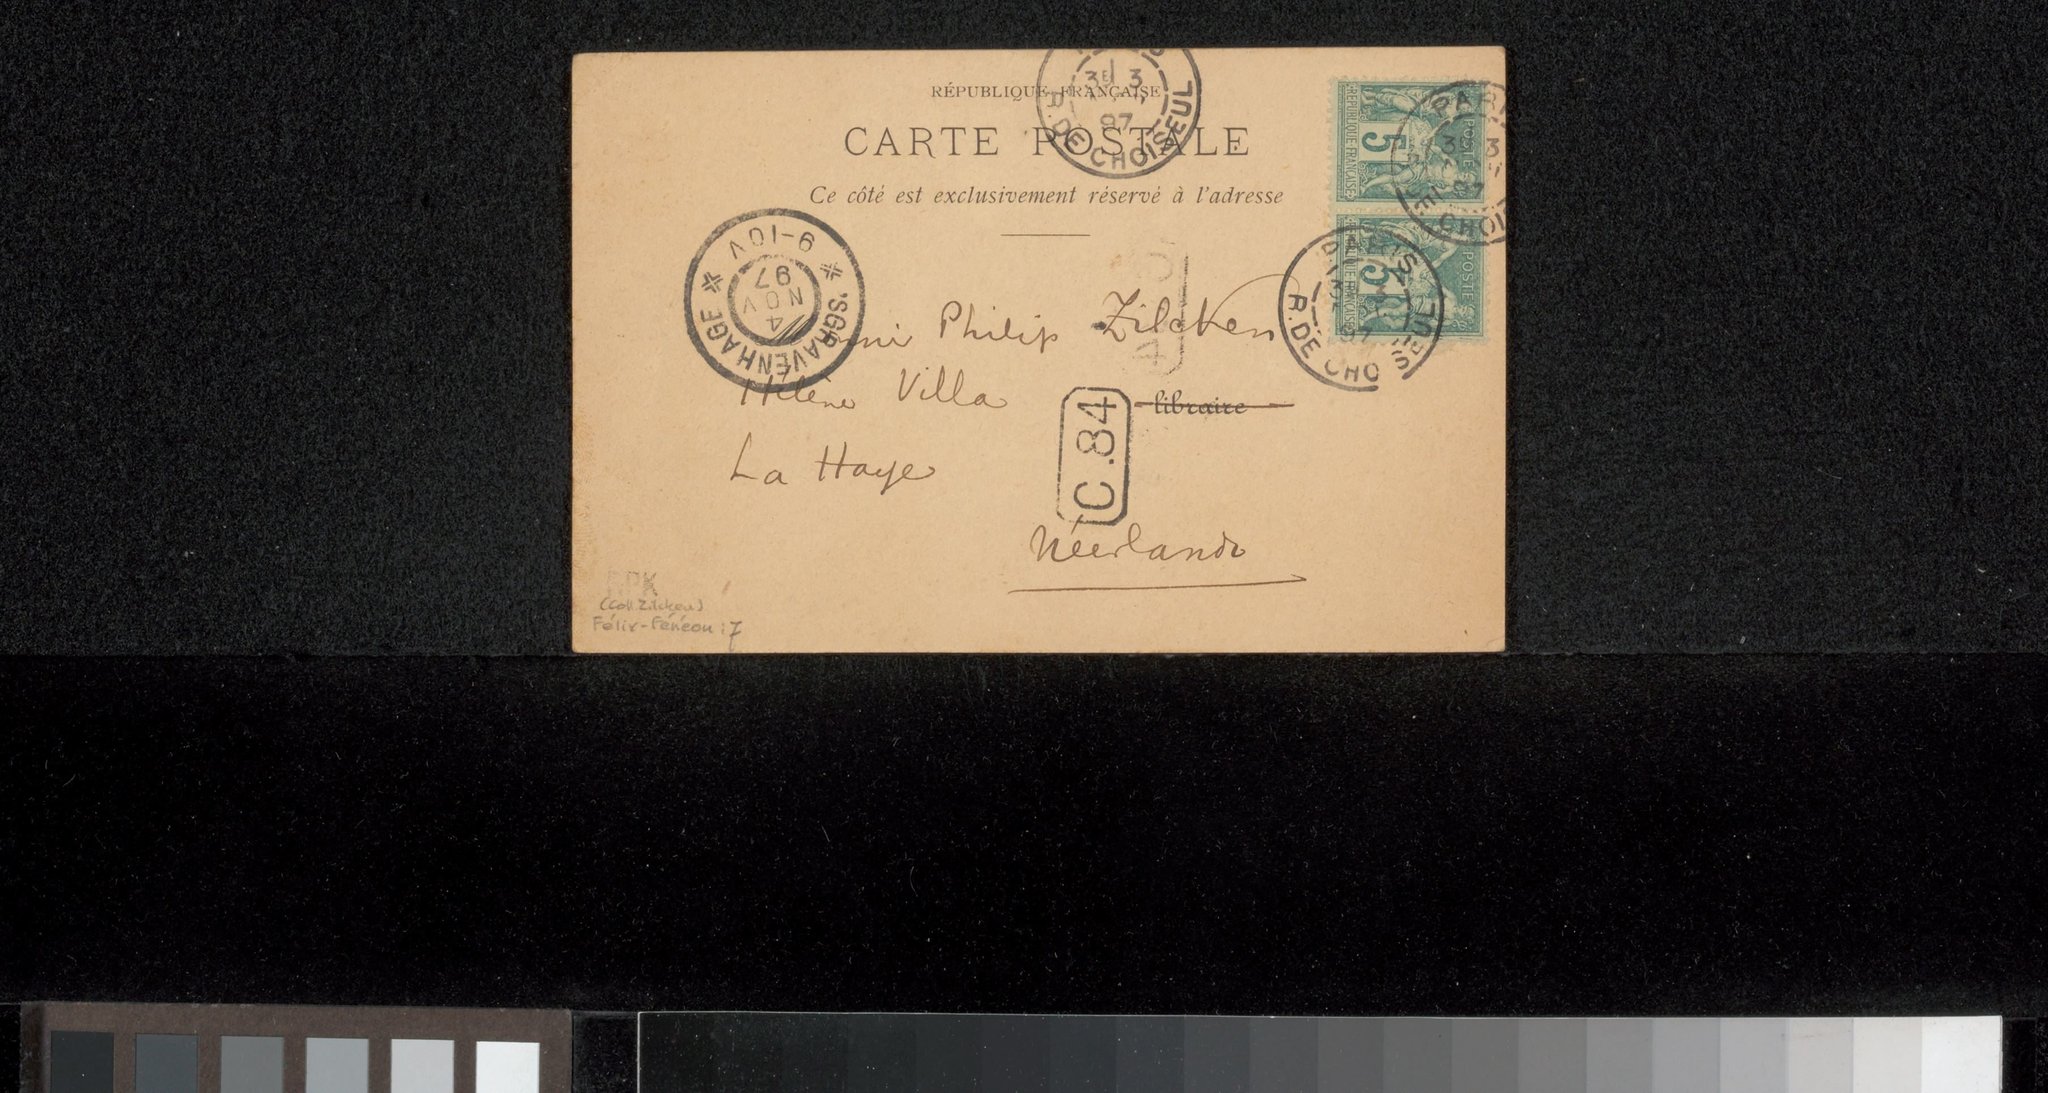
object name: postcard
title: Briefkaart aan Philip Zilcken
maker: félix fénéon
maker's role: handelaar, kunstcriticus, verzamelaar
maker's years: 1861-1944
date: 1897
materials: cardboard, ink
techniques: pen, writing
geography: paris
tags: lodewijk van deyssel, painter, draughtsman, philip zilcken, literature ~ arts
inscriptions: collector's mark: ‘RPK’